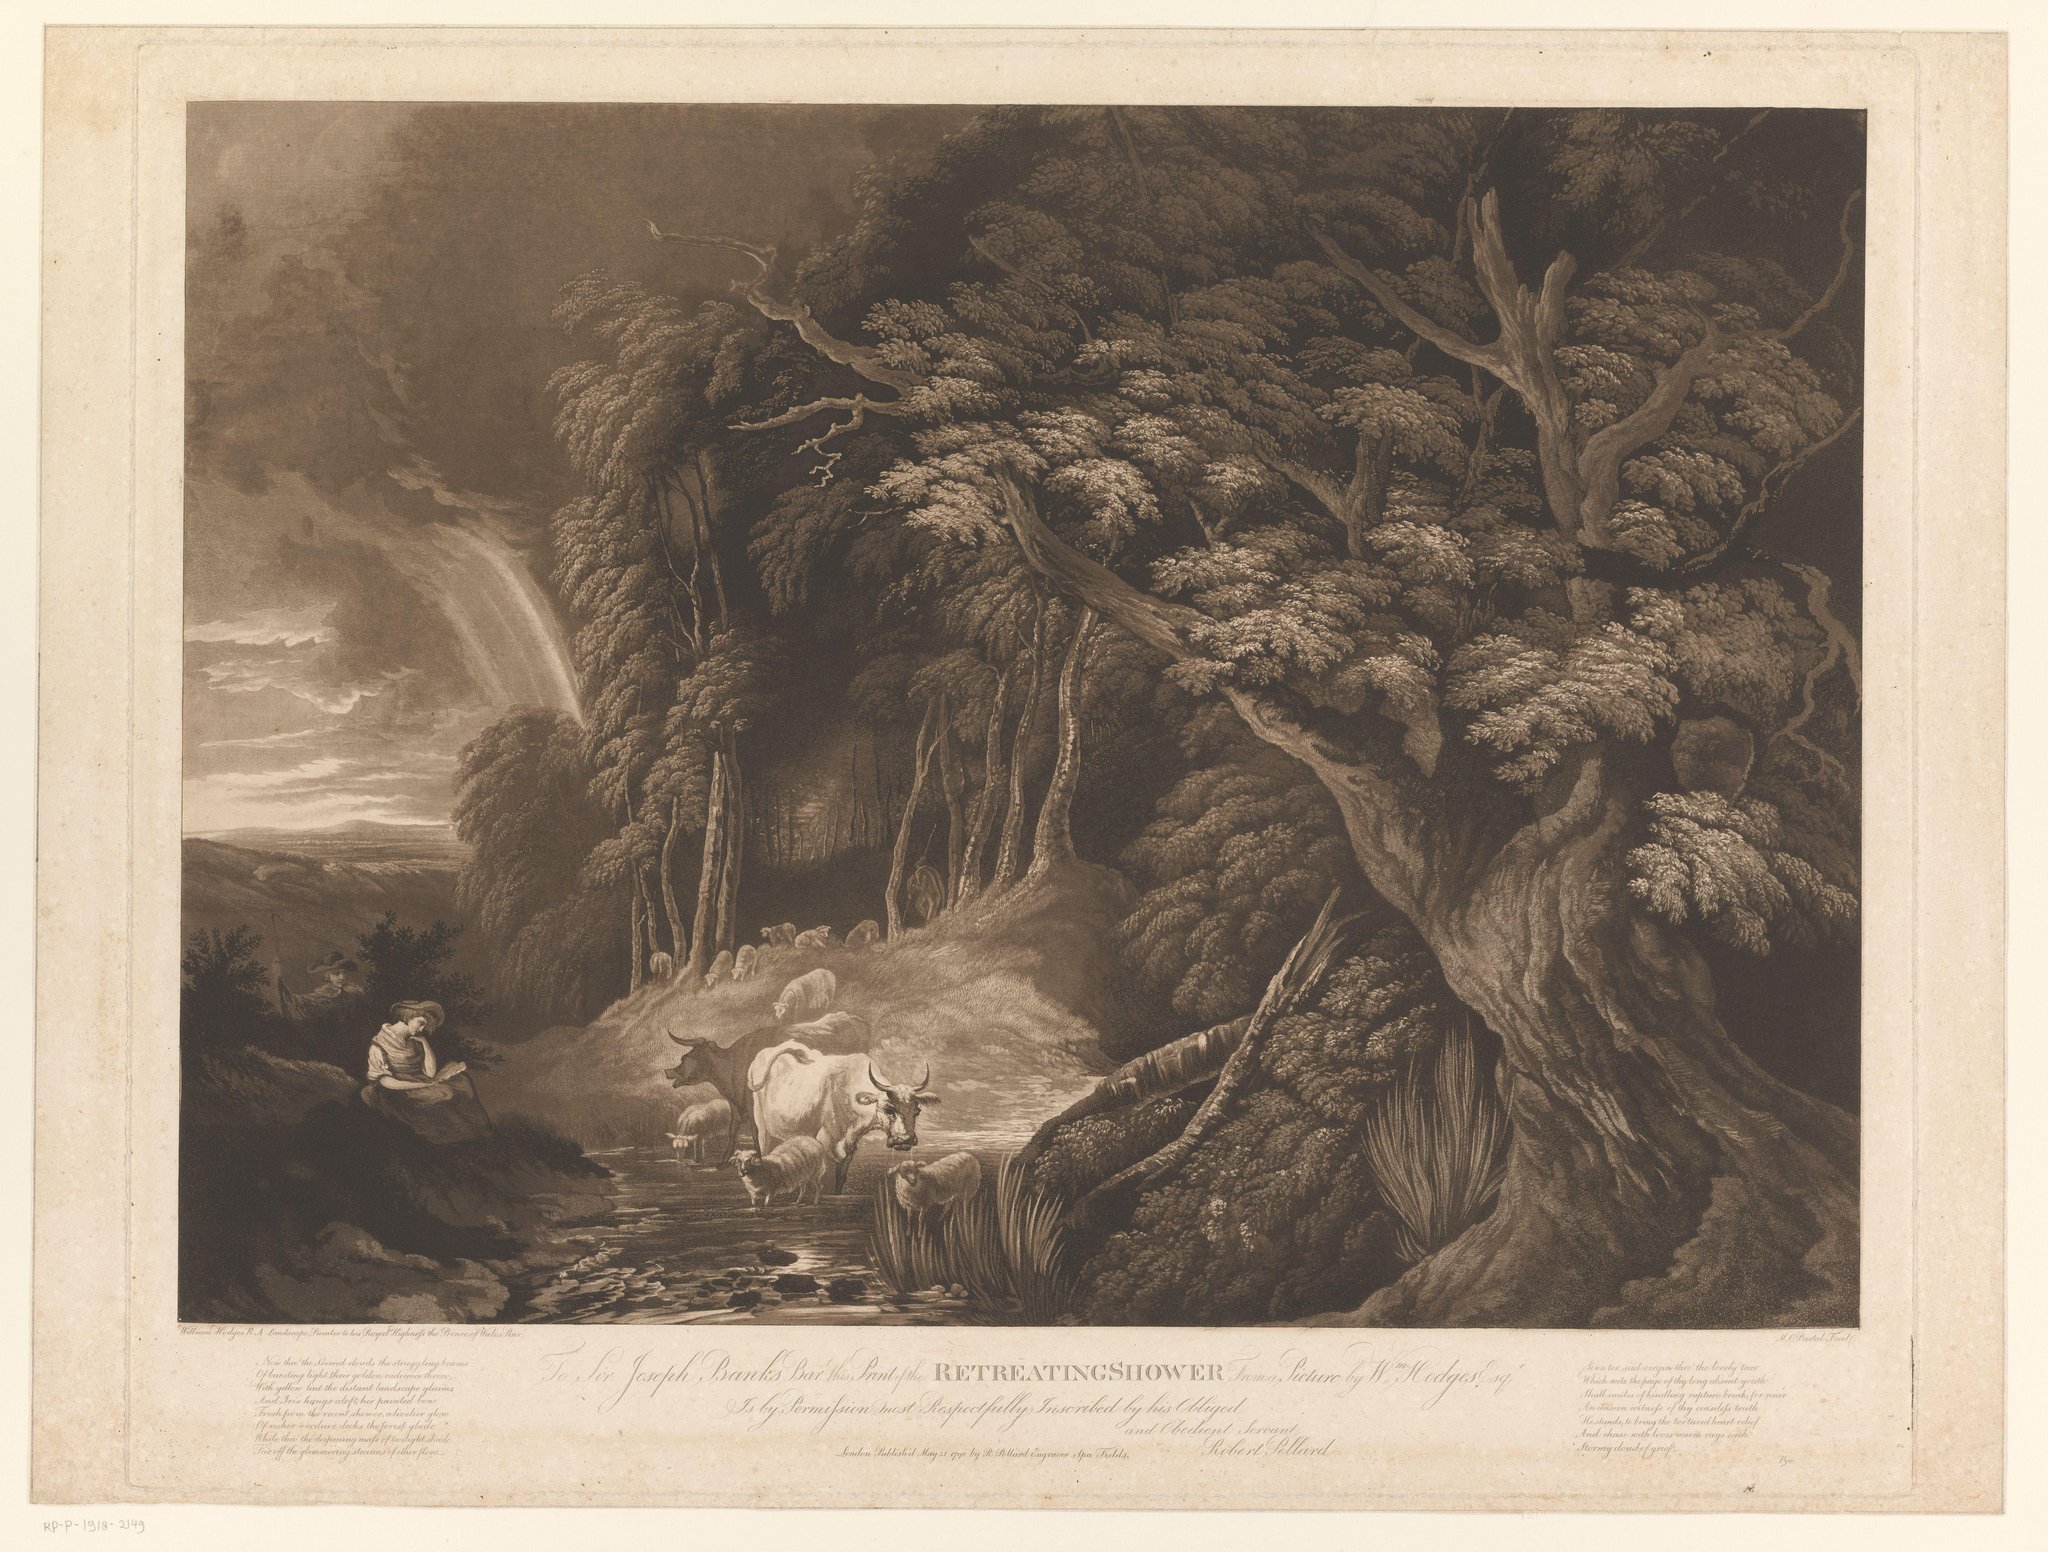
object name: print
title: Retreating shower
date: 1790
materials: paper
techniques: aquatint, etching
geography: london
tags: downpour, rain shower, herding, herdsman, herdswoman, shepherd, shepherdess, cowherd, etc., (traveller) resting in the open air, low hill country (+ landscape with figures, staffage), brook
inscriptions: collector's mark: Lugt 2233